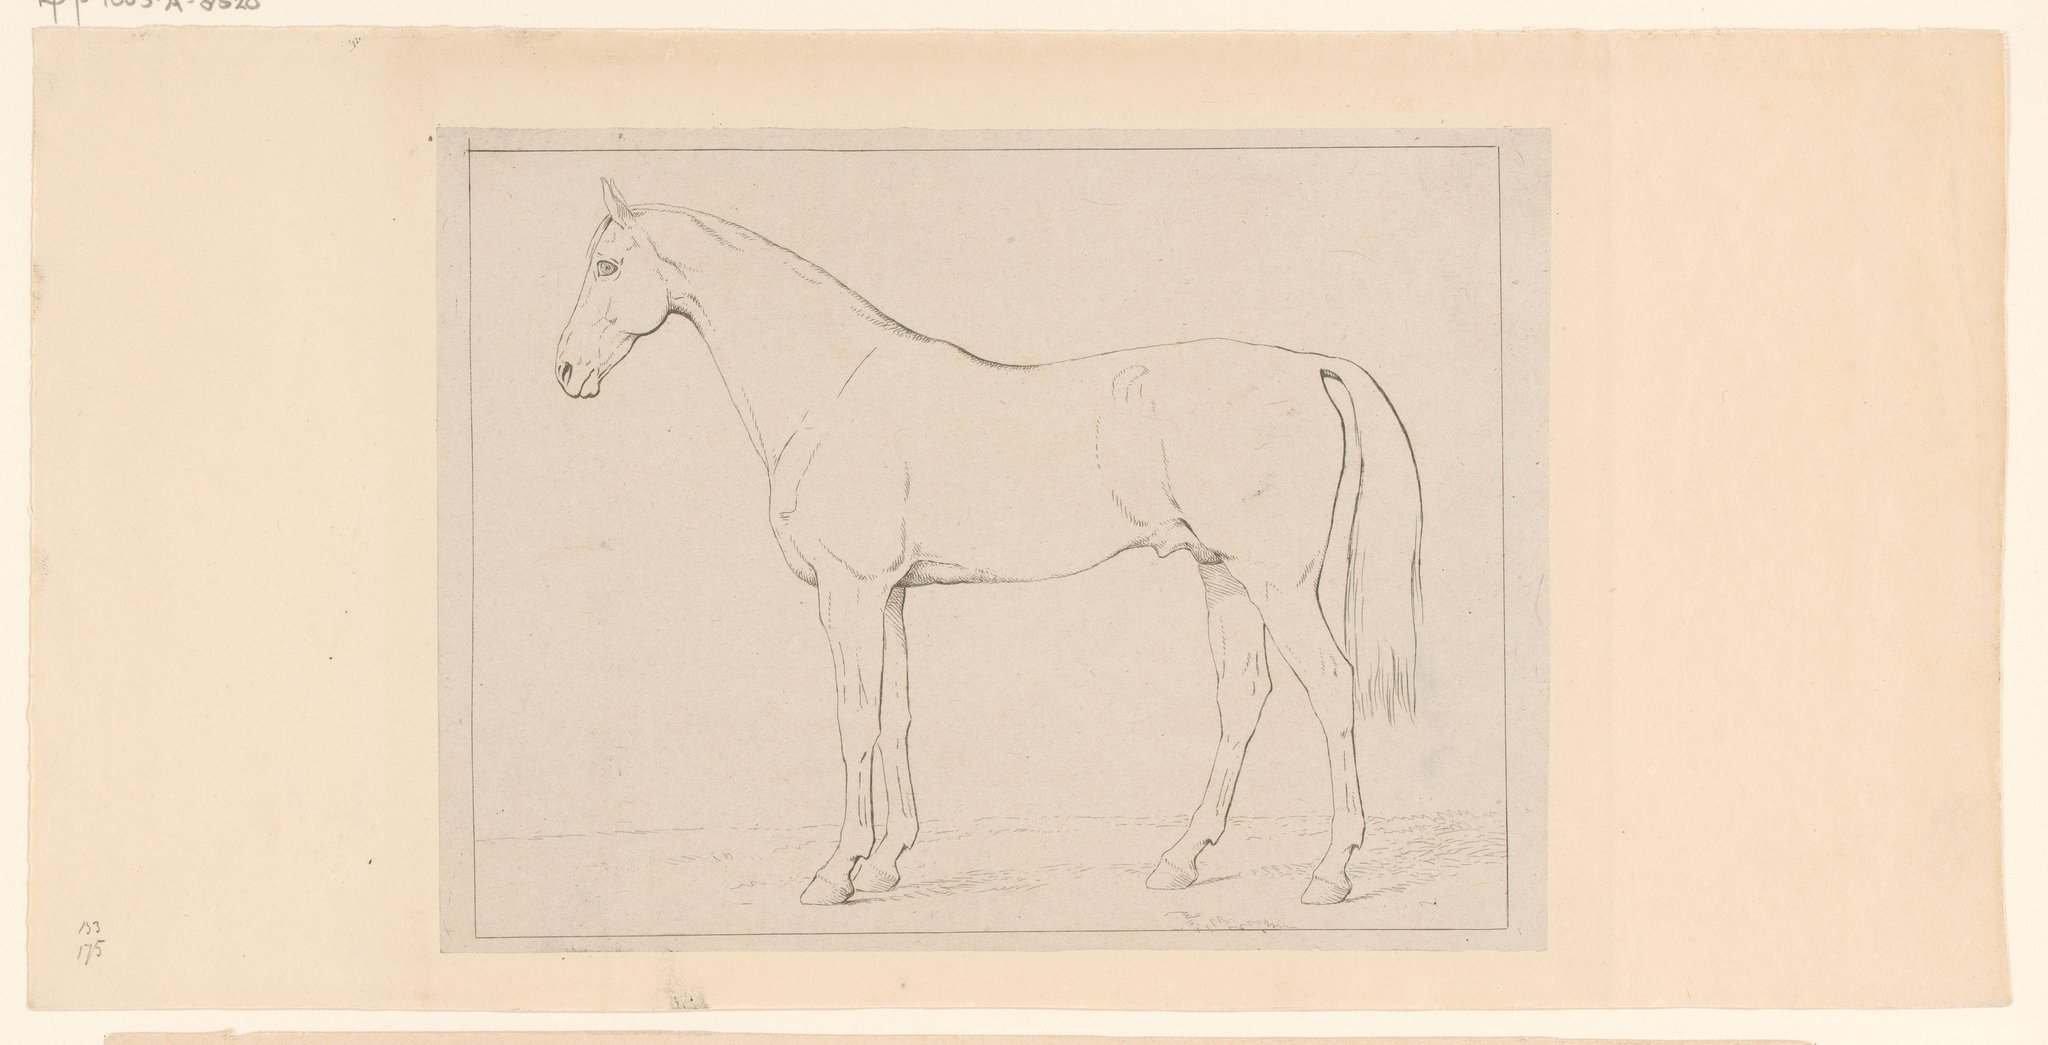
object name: print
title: Staand paard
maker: charles tschaggeny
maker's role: print maker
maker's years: 1815-1894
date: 1825-1885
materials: paper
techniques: etching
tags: horse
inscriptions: collector's mark: Lugt 2228